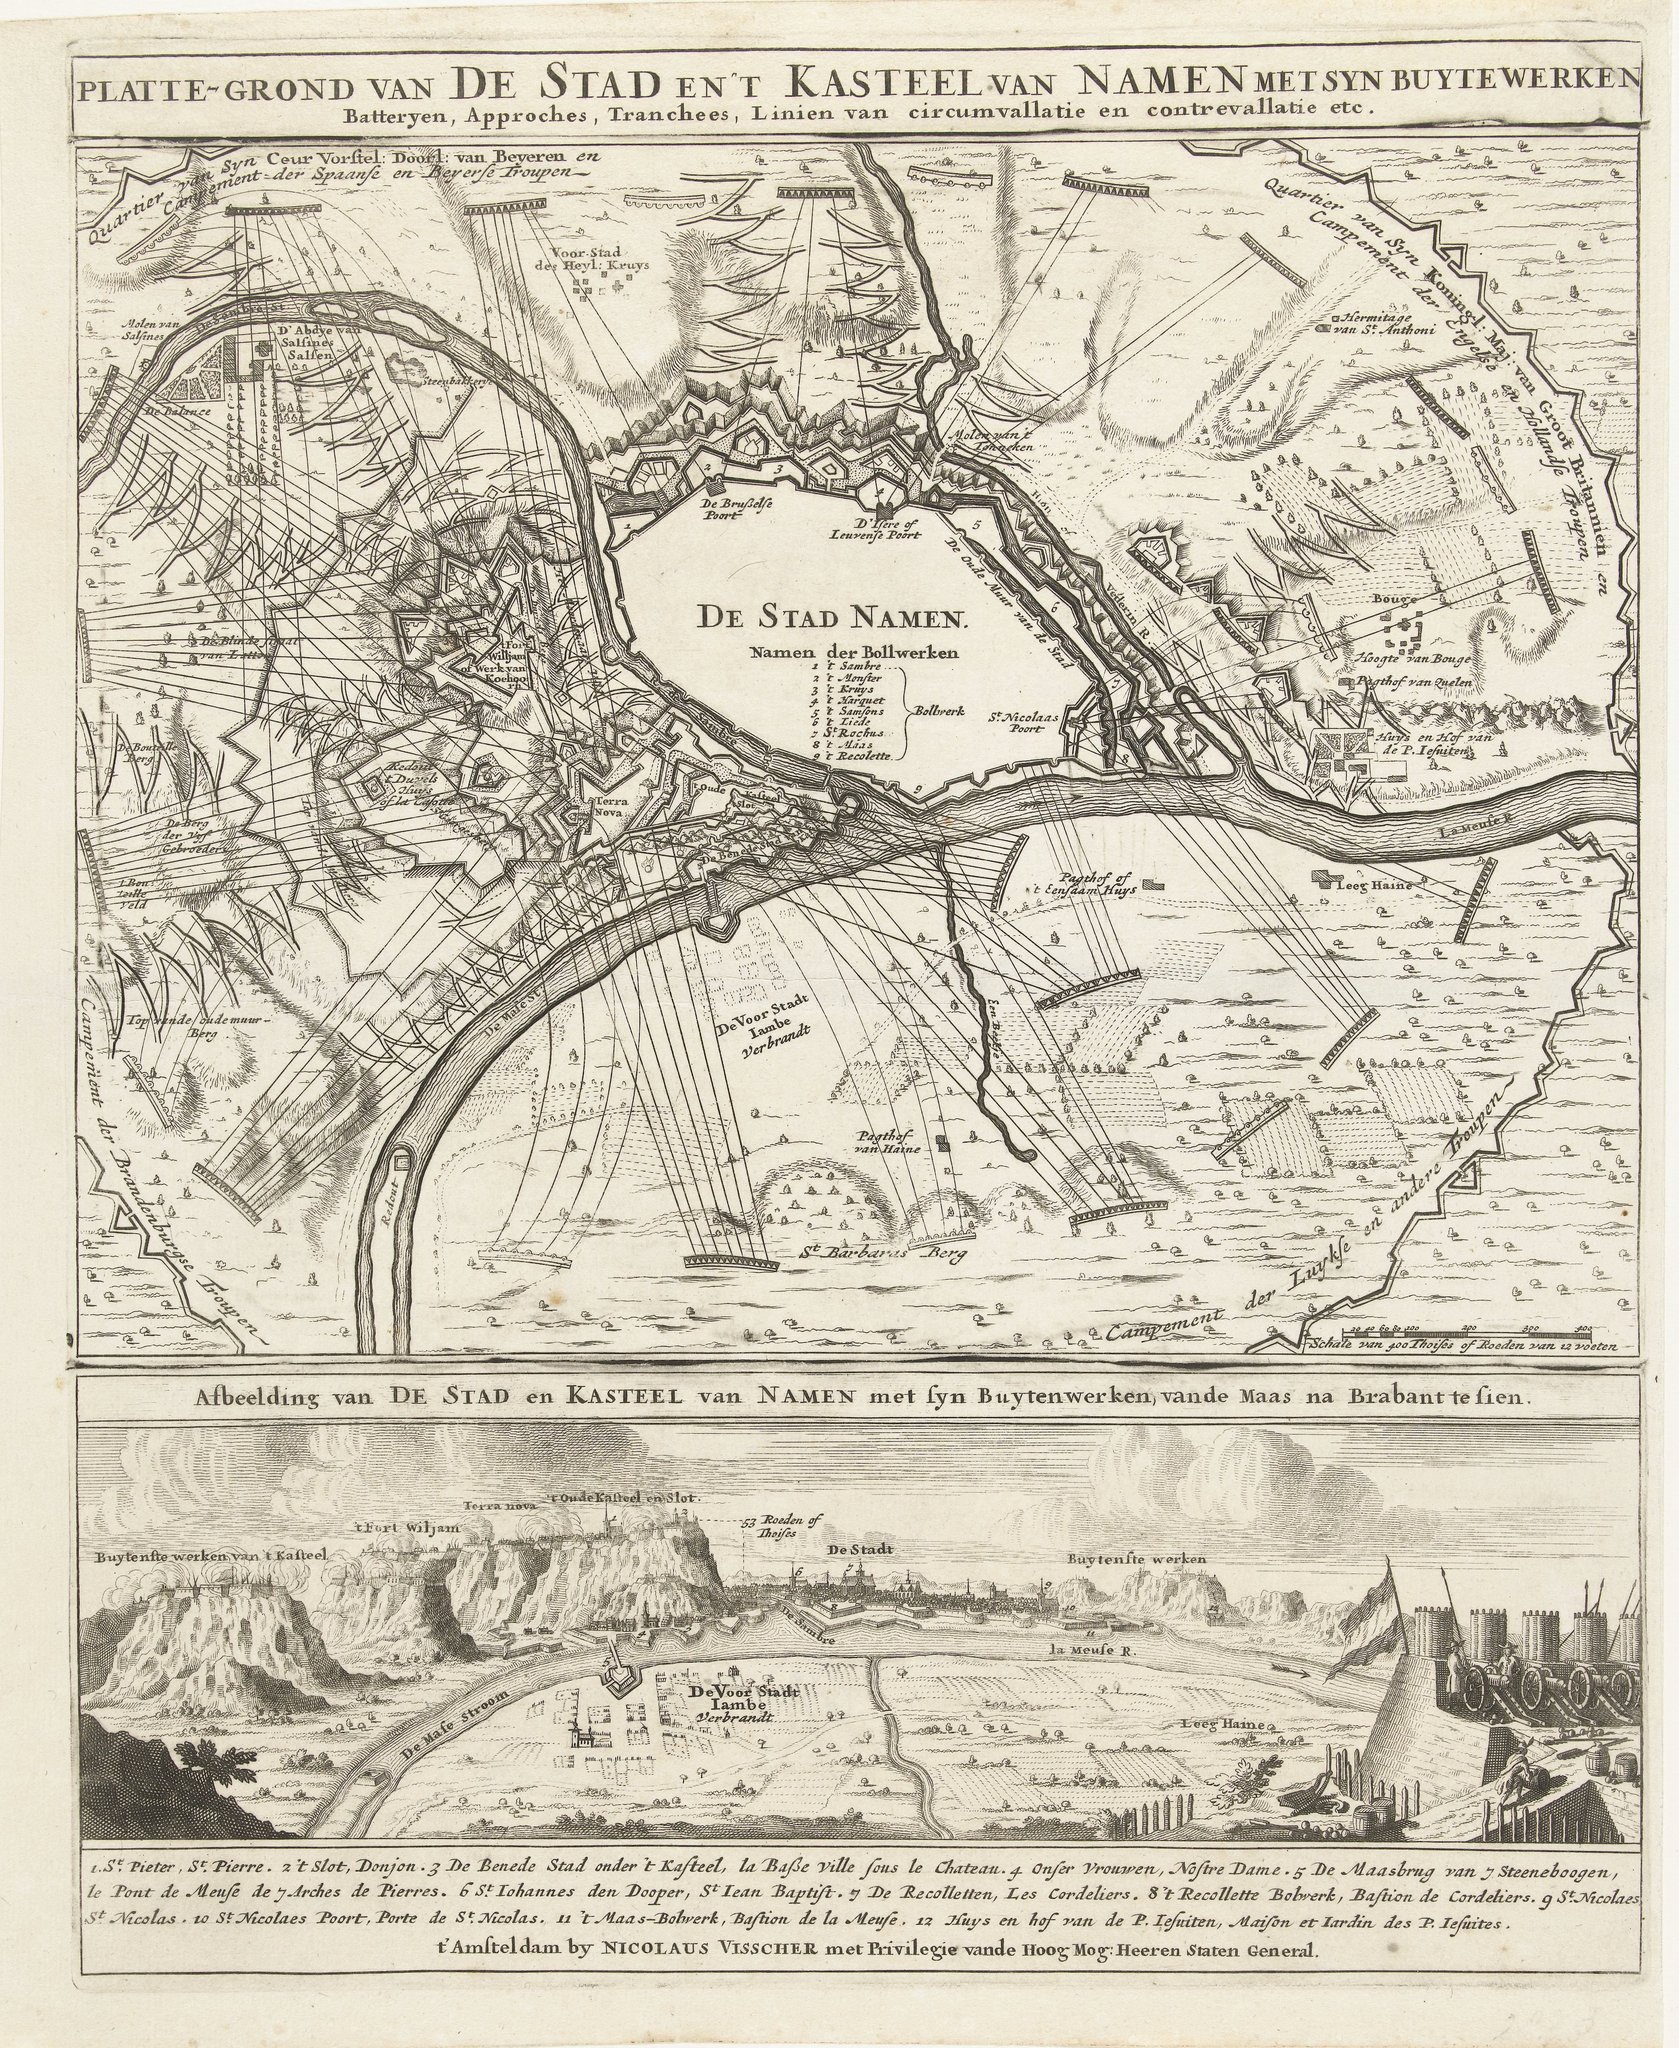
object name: print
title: Beleg van Namen, 1695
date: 1695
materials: paper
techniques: etching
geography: amsterdam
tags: william iii (prince of orange and king of england, scotland, and ireland), siege, position war, maps of cities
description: Beleg van Namen door de geallieerden onder koning Willem III, vanaf 3 juli 1695. Blad waarvan de voorstelling en titel van drie platen zijn gedrukt. In het midden een plan van Namen en de directe omgeving met de posities van de troepen. Hieronder een gezicht op de stad vanuit de posities van de belegeraars. In de voorstelling van deze prent zijn nieuwe posities en lijnen toegevoegd. Exemplaar zonder begeleidende teksten.